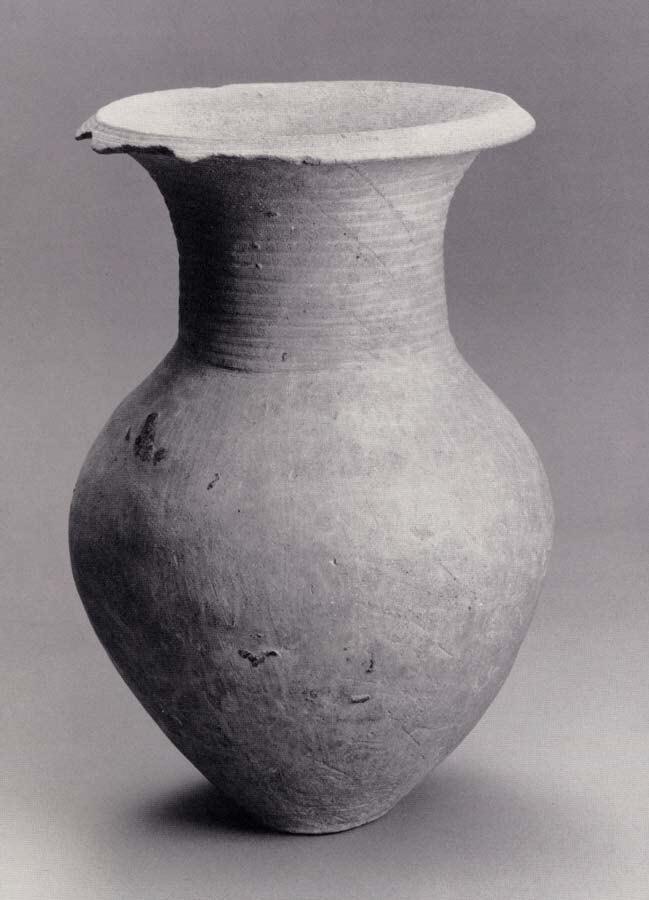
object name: jar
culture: japanese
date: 100-300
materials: earthenware